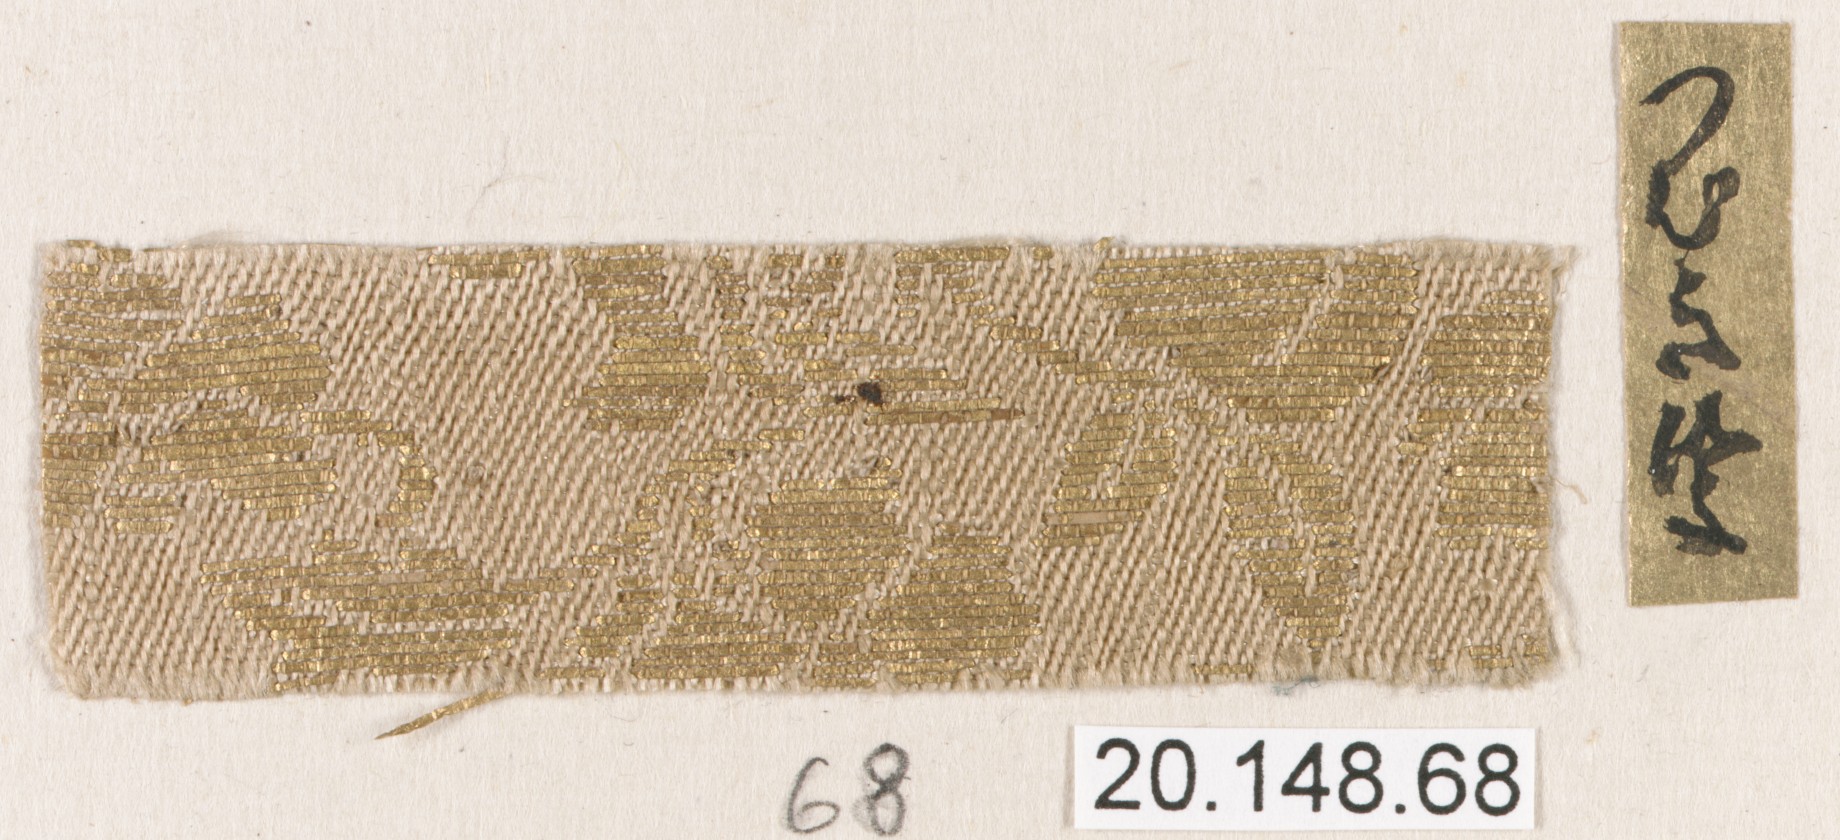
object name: piece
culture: japanese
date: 1501-1600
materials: silk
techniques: compound weave